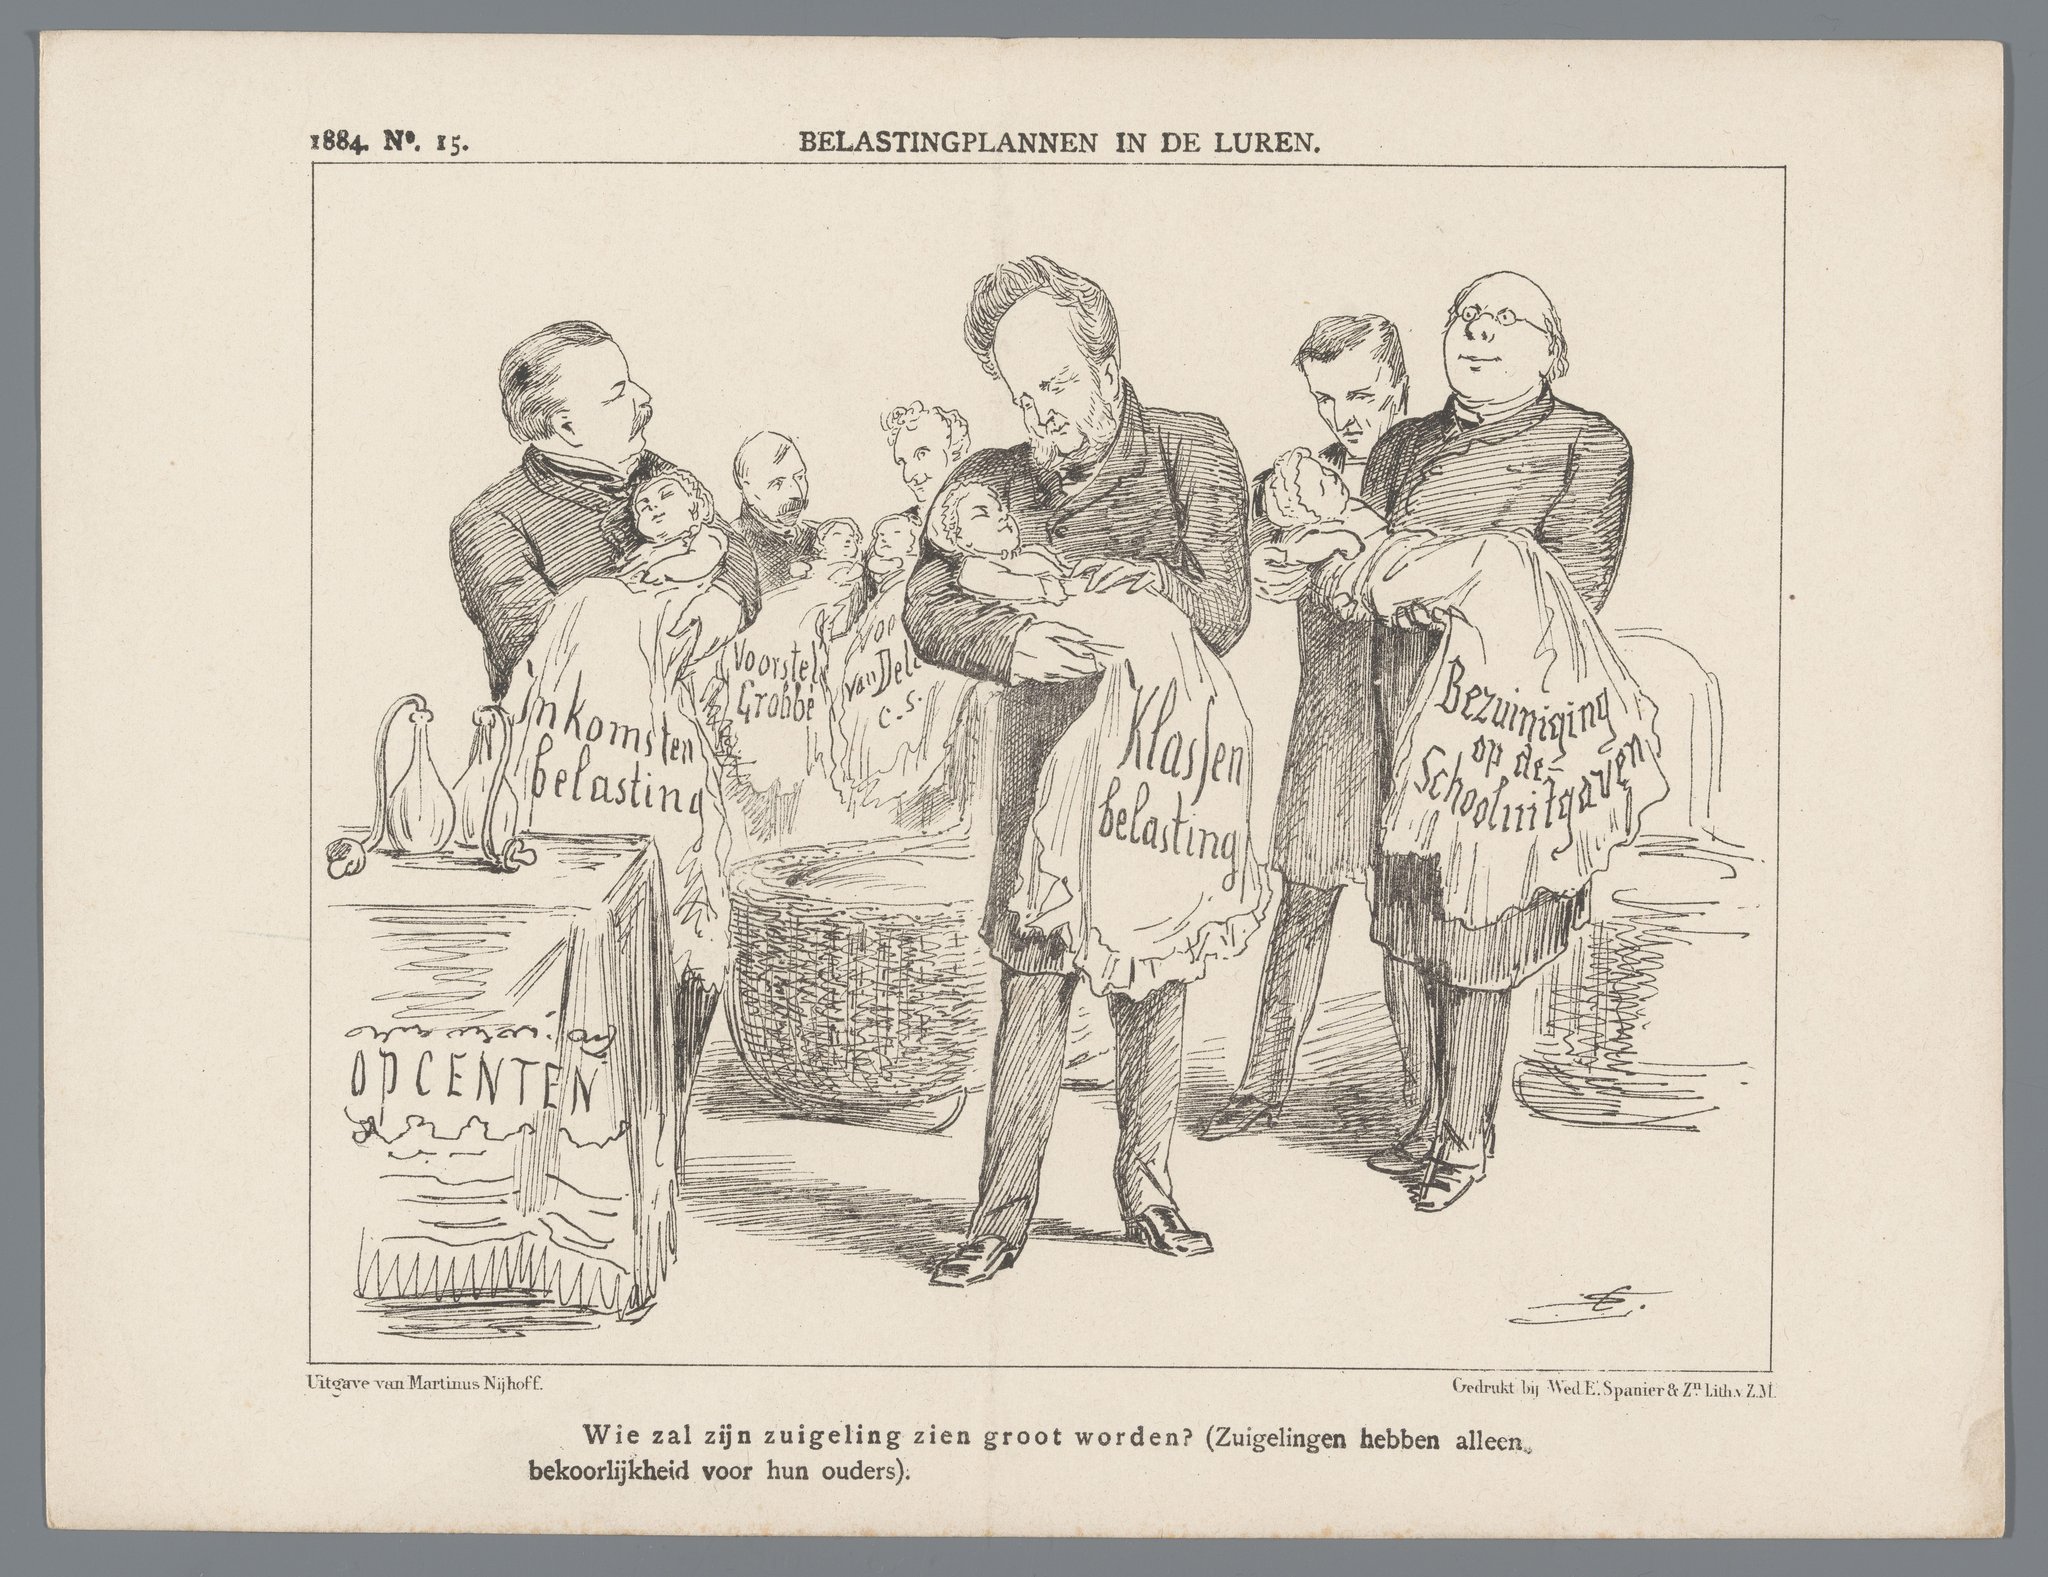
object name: print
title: Politieke spotprent over de belastingplannen, 1884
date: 1884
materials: paper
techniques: lithograph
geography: the hague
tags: amsterdam, politician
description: Politieke spotprent over de belastingplannen. De ministers met een kind in de armen. Plaat verschenen bij het weekblad De Nederlandsche Spectator, nr. 15, 1884.